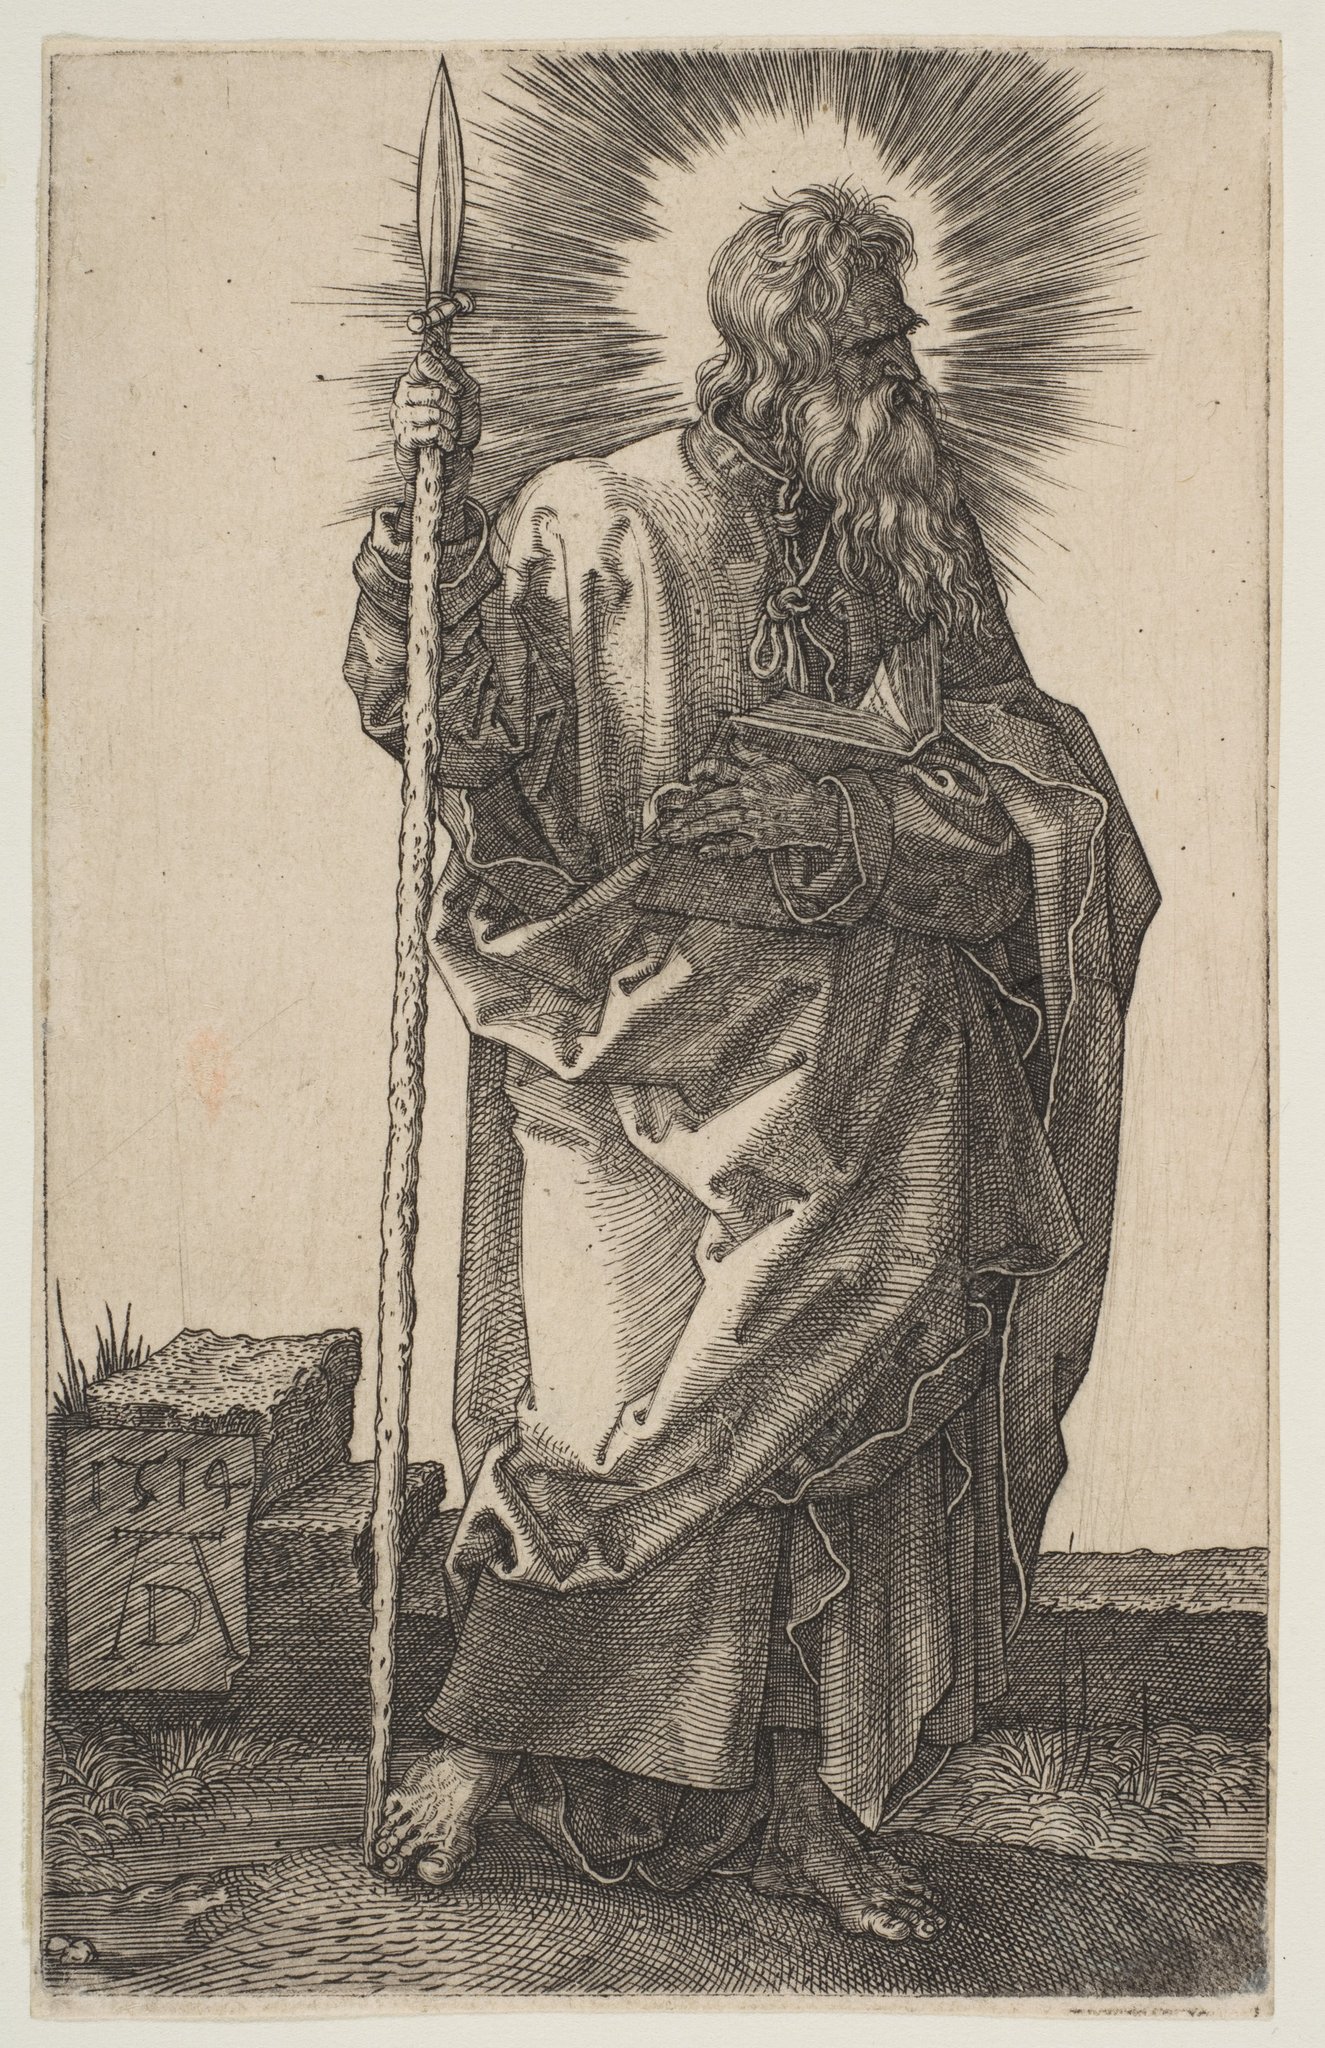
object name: print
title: Saint Thomas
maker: albrecht dürer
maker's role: artist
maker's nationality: german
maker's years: 1471-1528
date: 1514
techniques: engraving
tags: men,saints